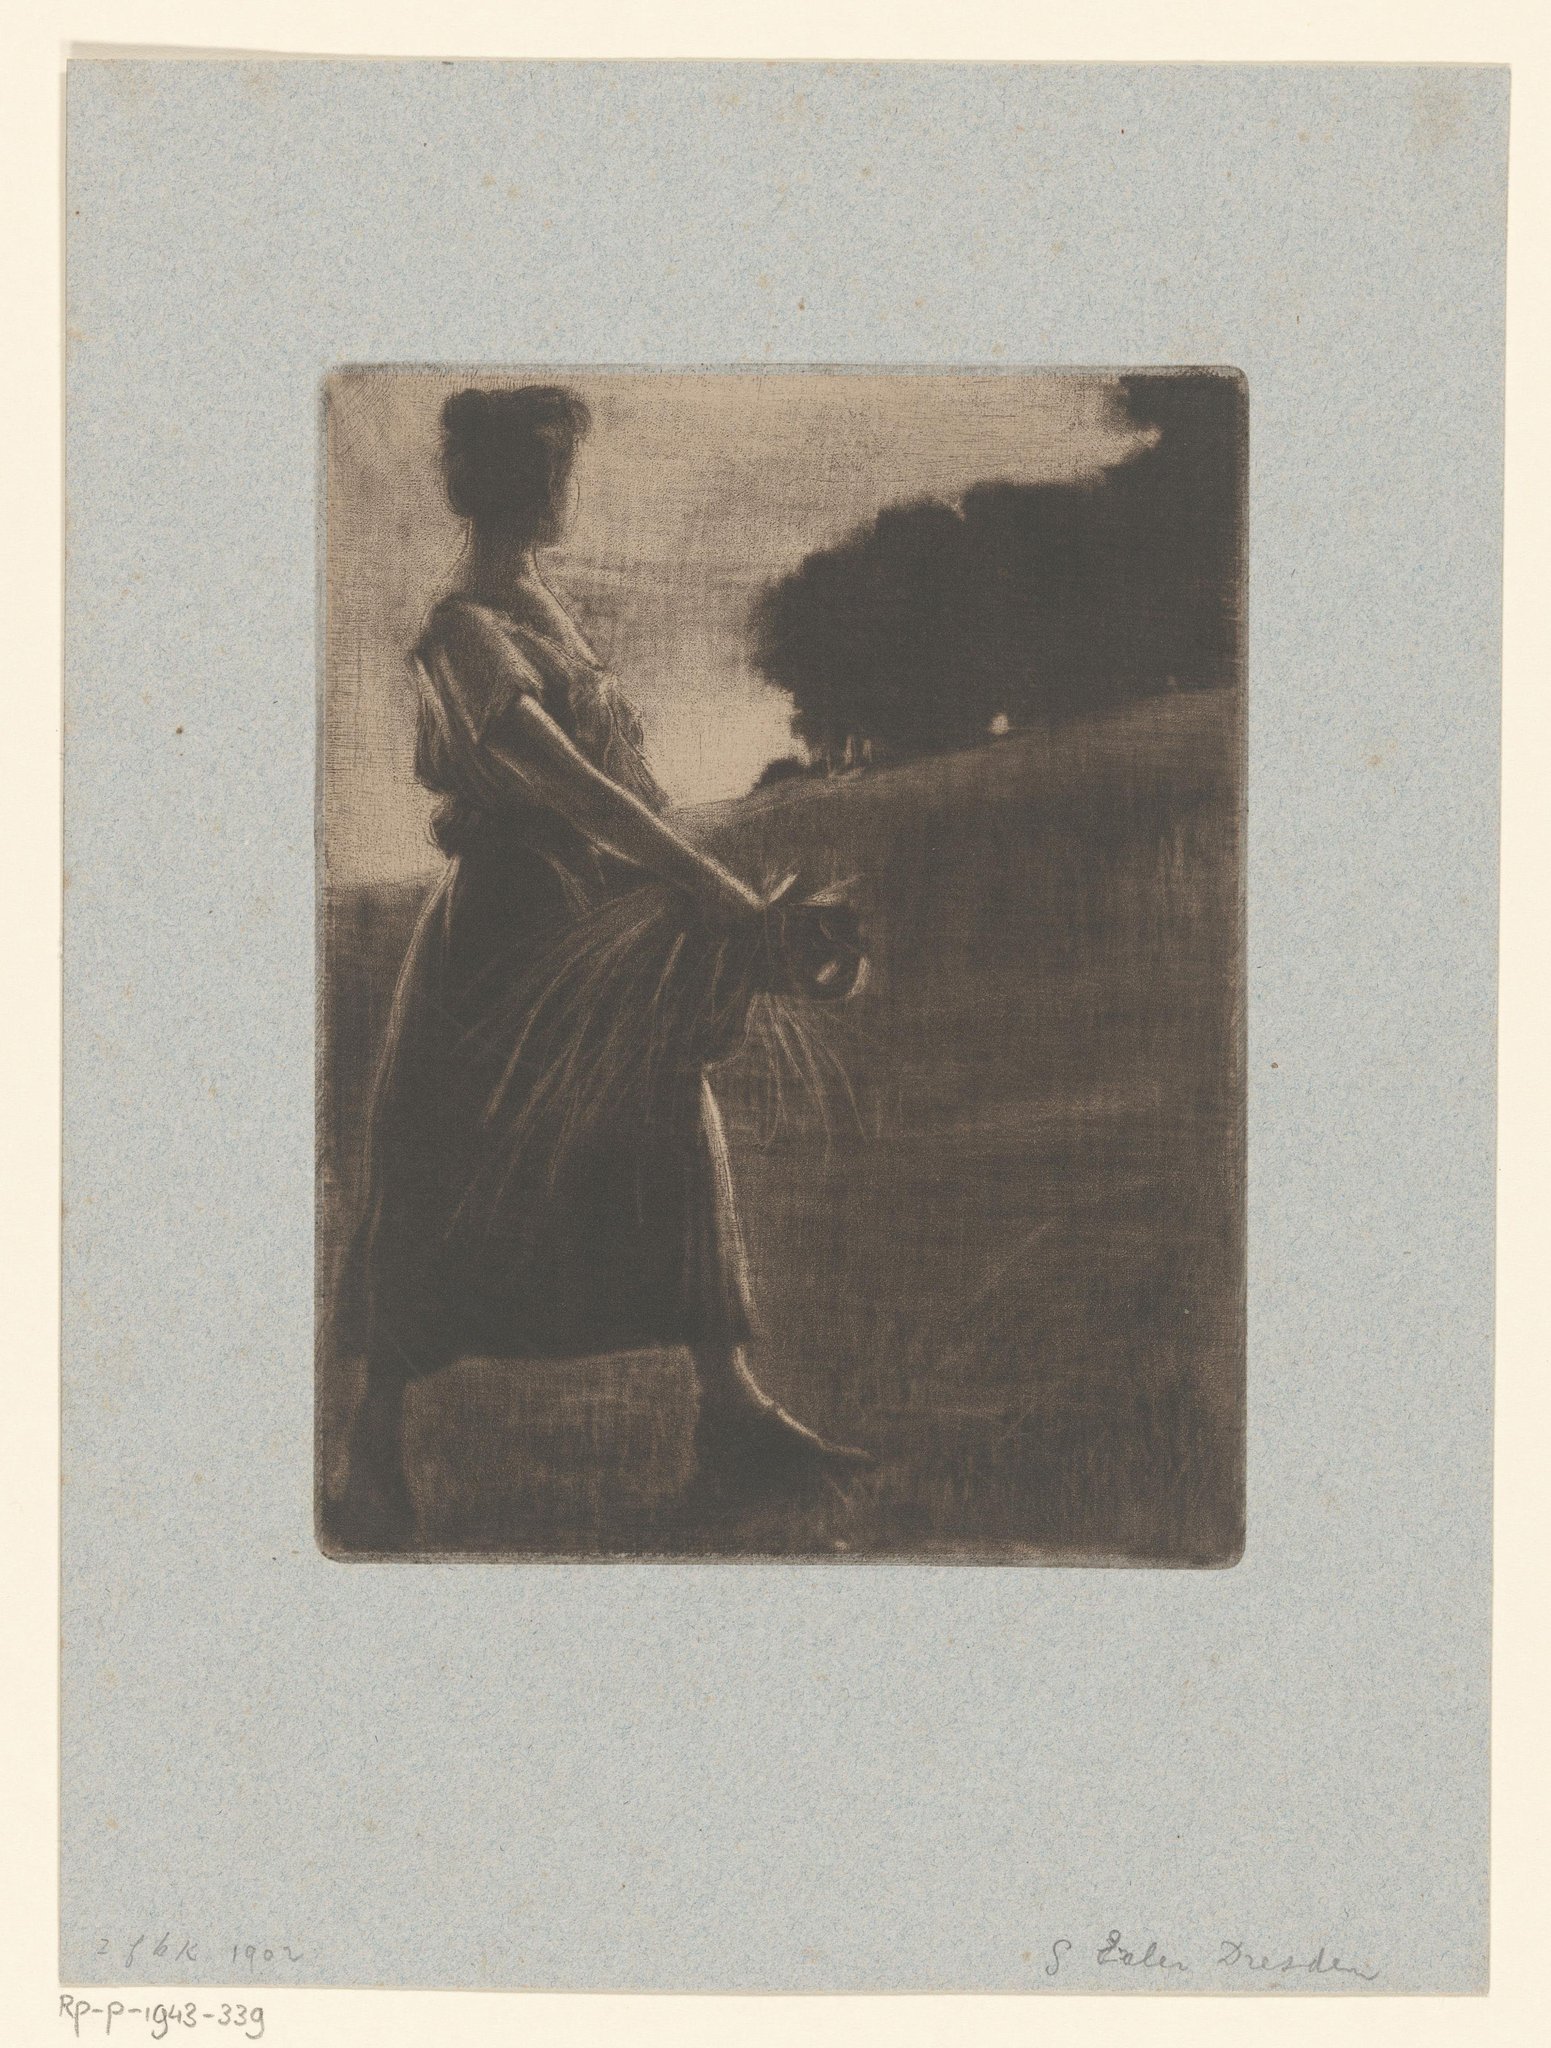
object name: print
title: Arenlezende vrouw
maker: georg oskar erler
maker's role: print maker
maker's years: 1871-1951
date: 1902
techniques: printmaking, etching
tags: adolescent, young woman, maiden, meadow, pasture, cereal, grain, corn (grass with grains, grown for food, e.g.: wheat, rice, rye, oats, maize, buckwheat, millet)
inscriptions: collector's mark: Lugt 2760, collector's mark: Lugt 2228